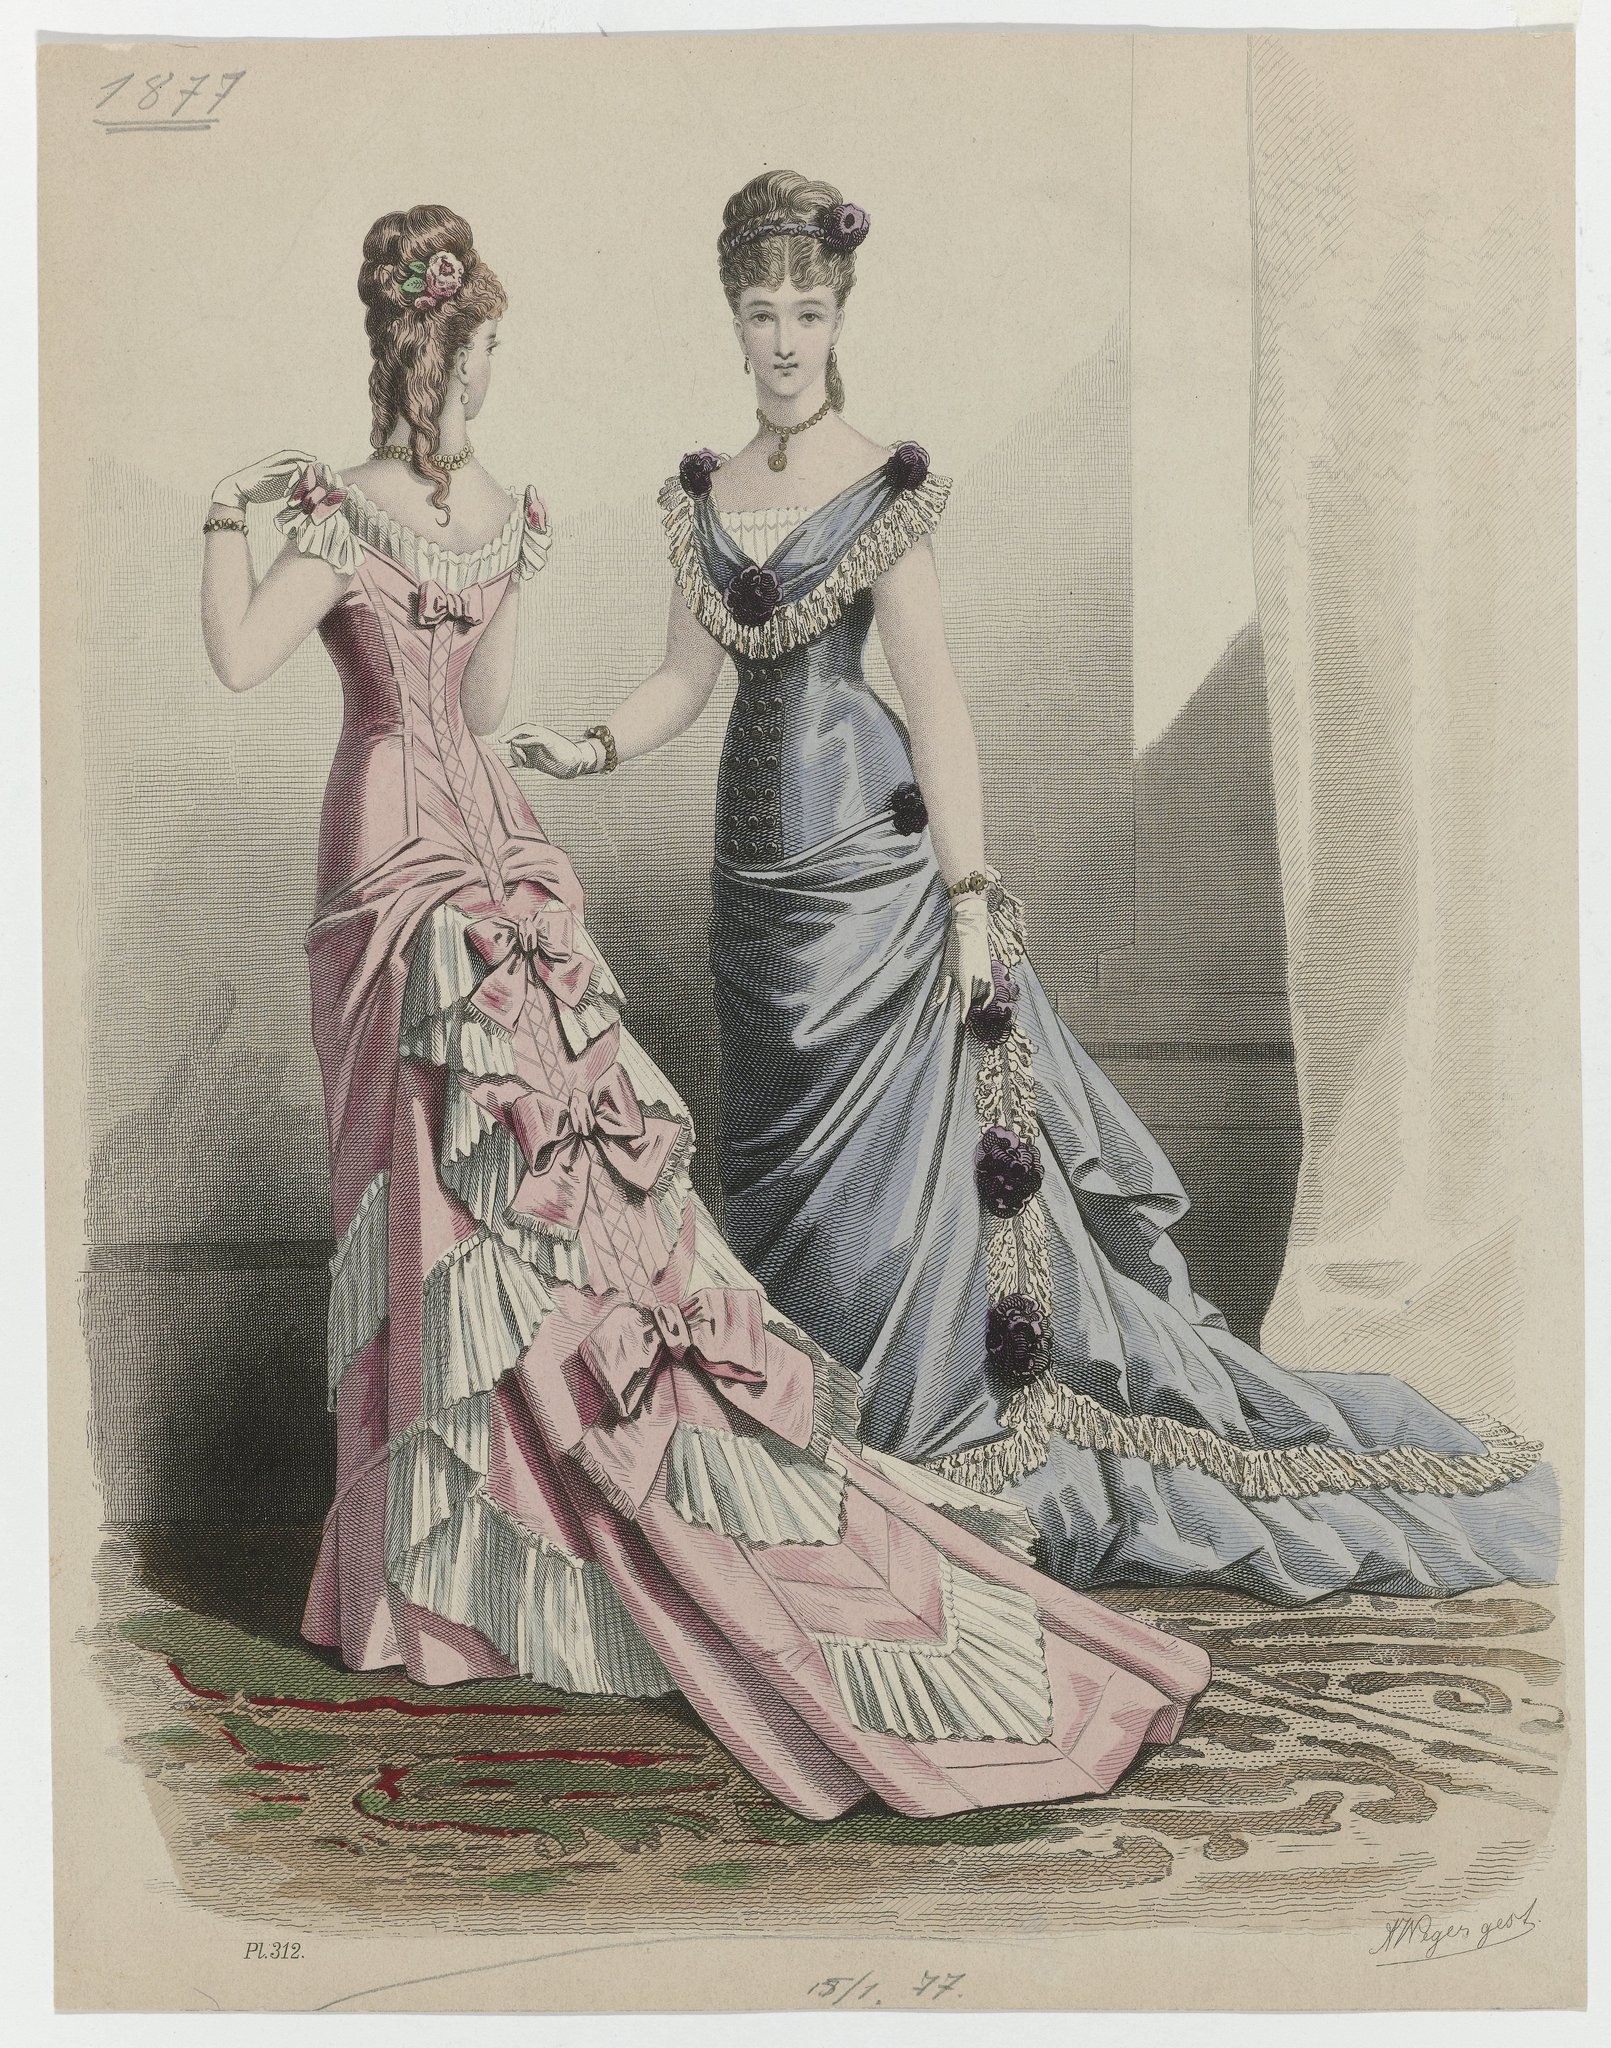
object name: fashion print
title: Illustrirte Frauen-Zeitung, 15 januari 1877, Pl. 312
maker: august weger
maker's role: print maker, printer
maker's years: 1823-1892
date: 1877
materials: paper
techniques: engraving, hand coloring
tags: flowers, ear-rings (+ women's clothes), diadem, tiara (+ women's clothes), dress, gown: evening dress (+ women's clothes), gloves, mittens (short gloves) (+ women's clothes), fashion plates, bracelet, wristlet (+ women's clothes), necklace (+ women's clothes)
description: Twee vrouwen in avondjaponnen met sleep. Accessoires: diadeem, oorbellen, collier, armbanden om beide polsen en korte handschoenen. Prent uit het modetijdschrift Illustrirte Frauen-Zeitung (1874-1911).